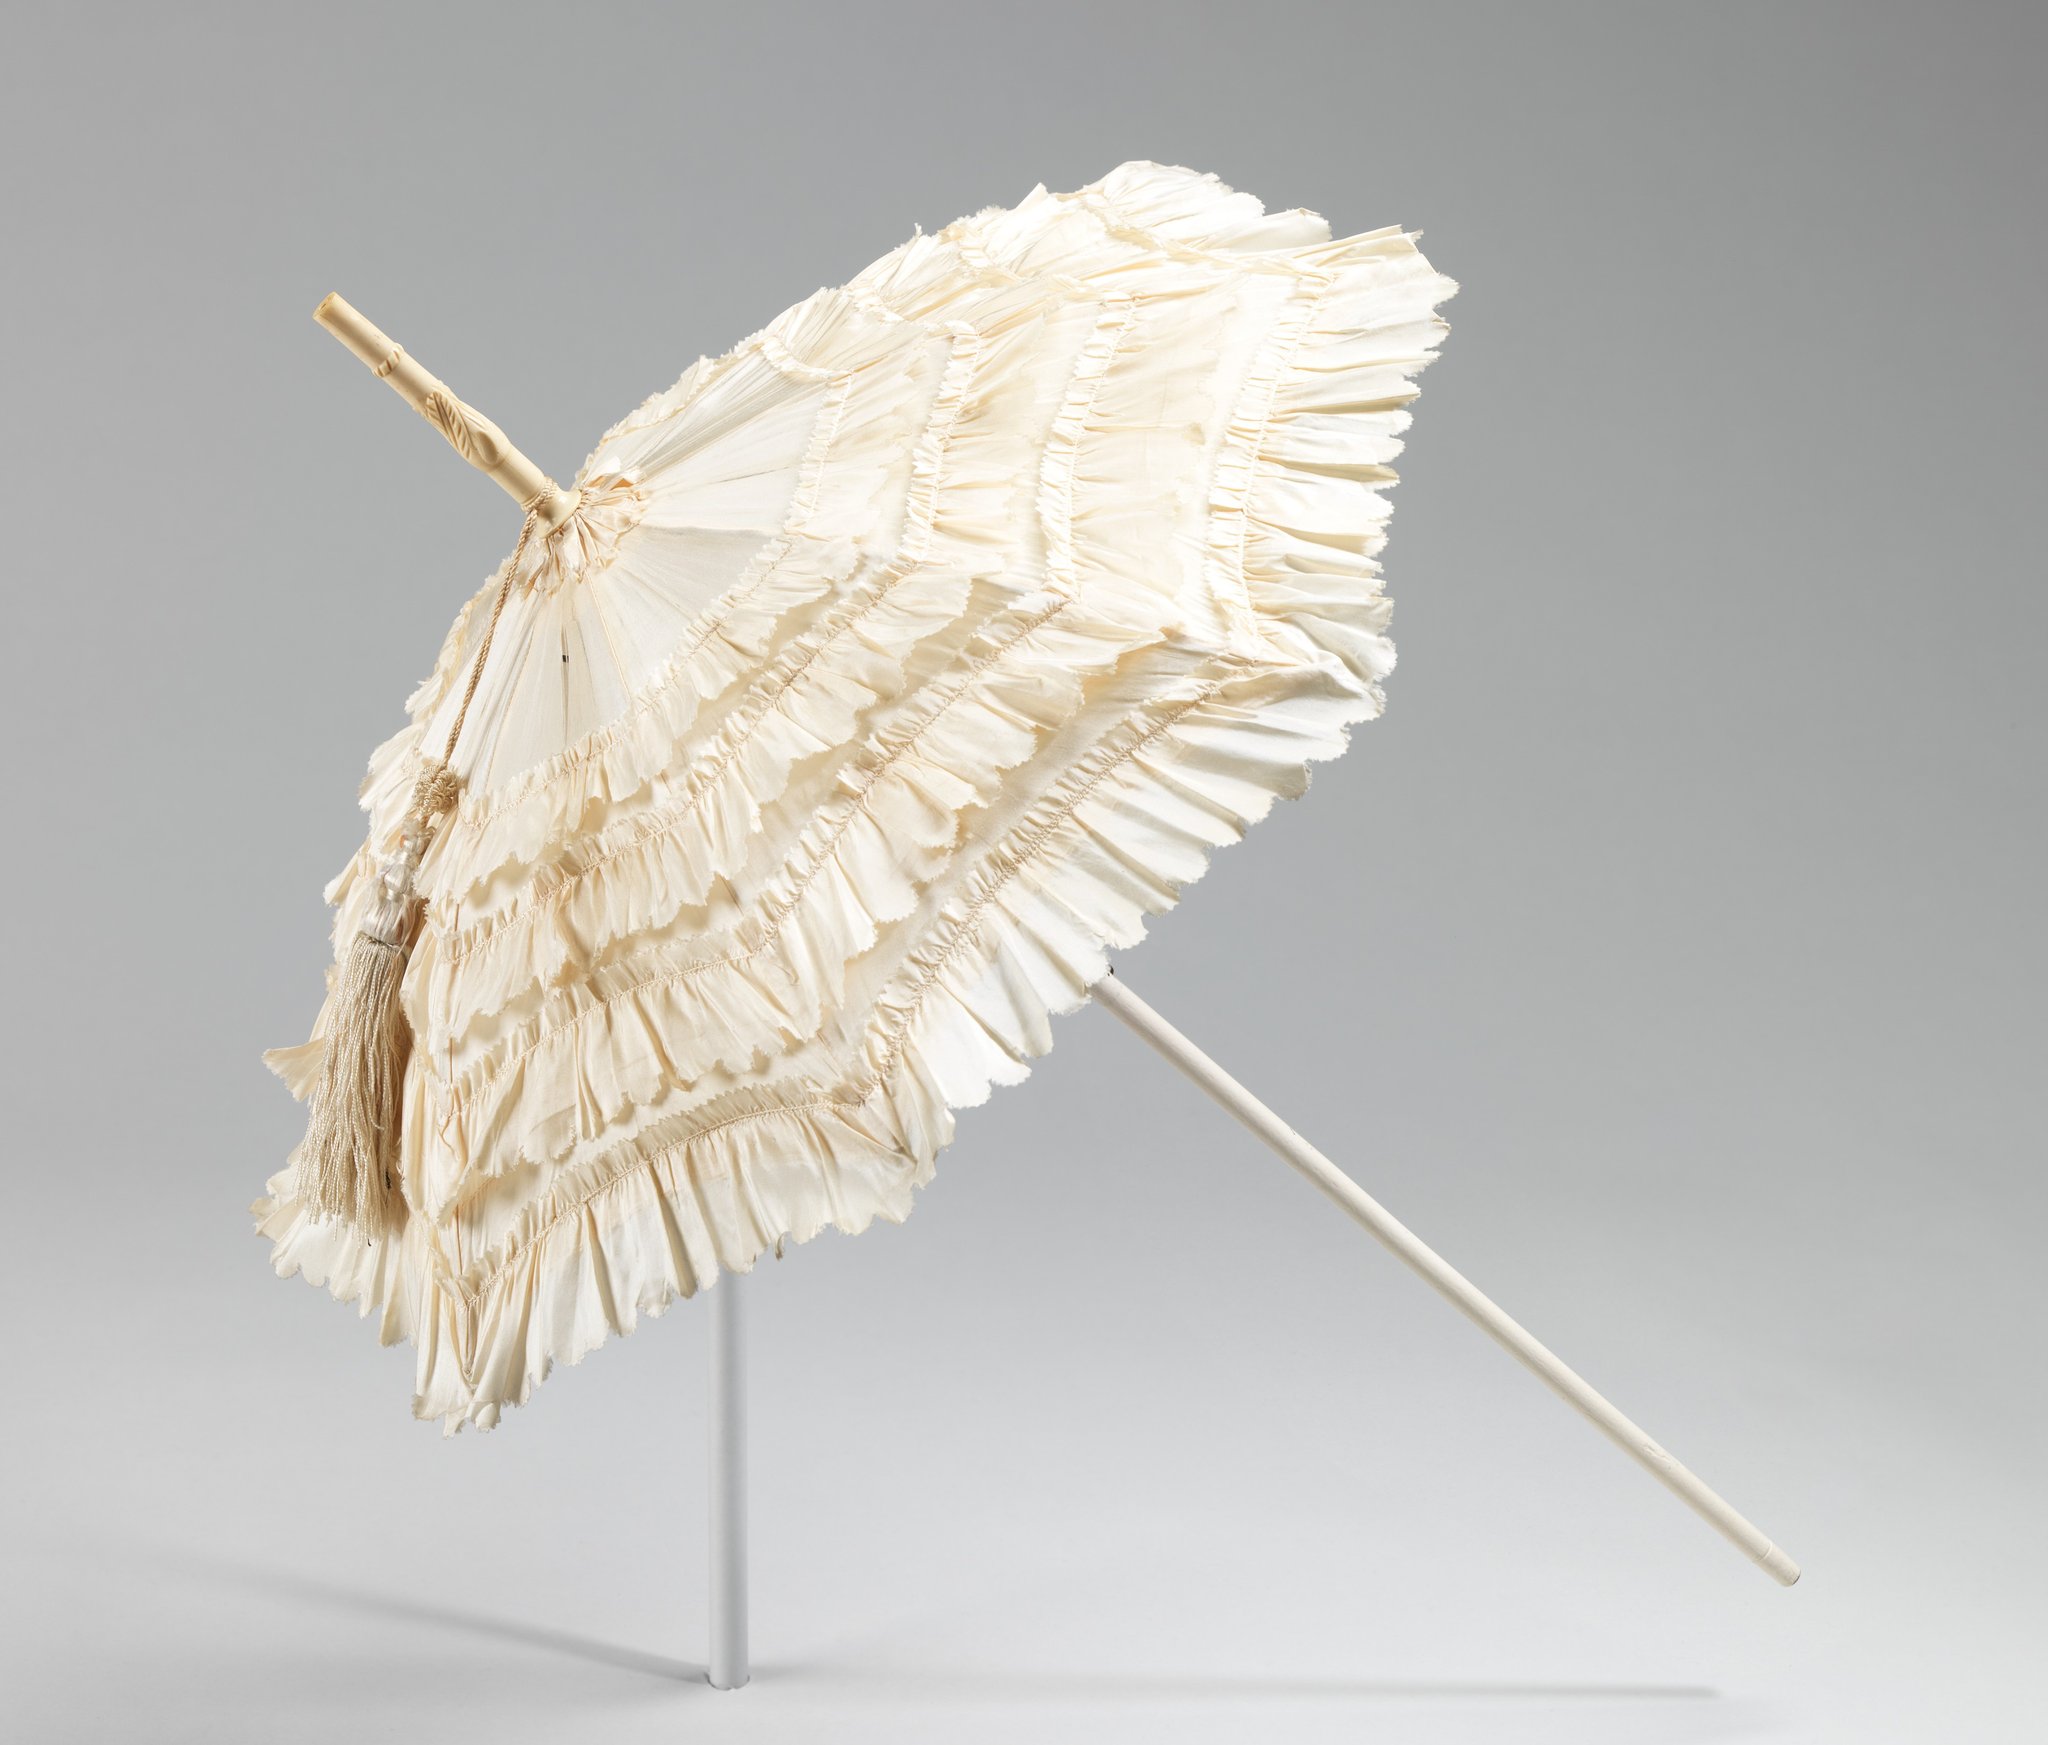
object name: parasol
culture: american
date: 1850-1860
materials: ivory, metal, silk, wood